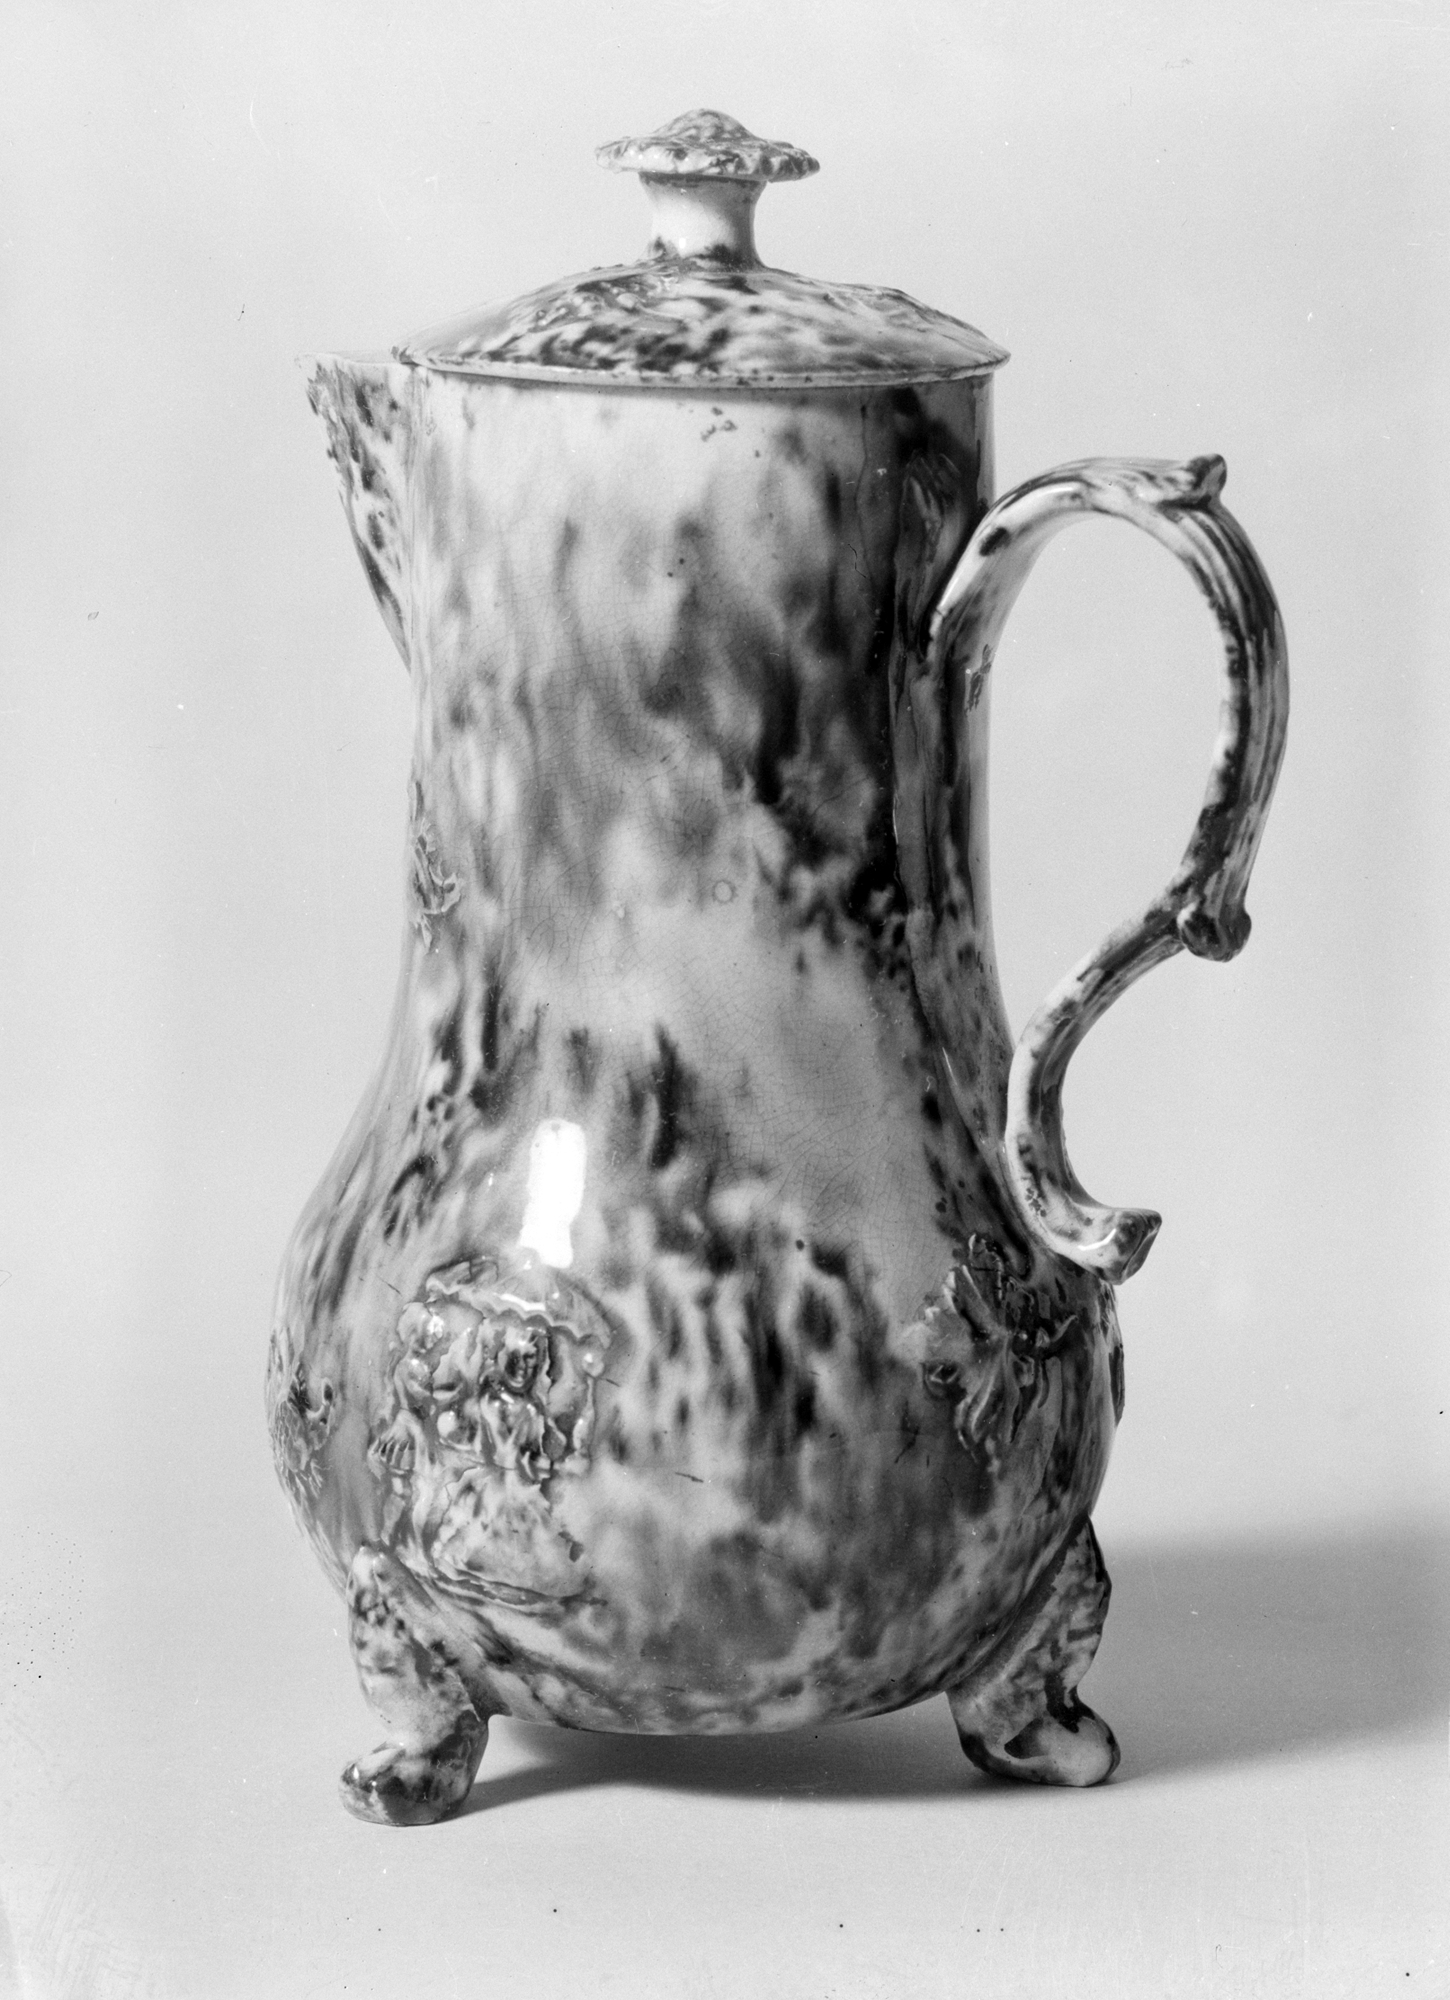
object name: milk jug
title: Covered milk jug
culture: british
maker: wedgwood-whieldon partnership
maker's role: maker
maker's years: 1754-1759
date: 1750-1760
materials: earthenware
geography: england